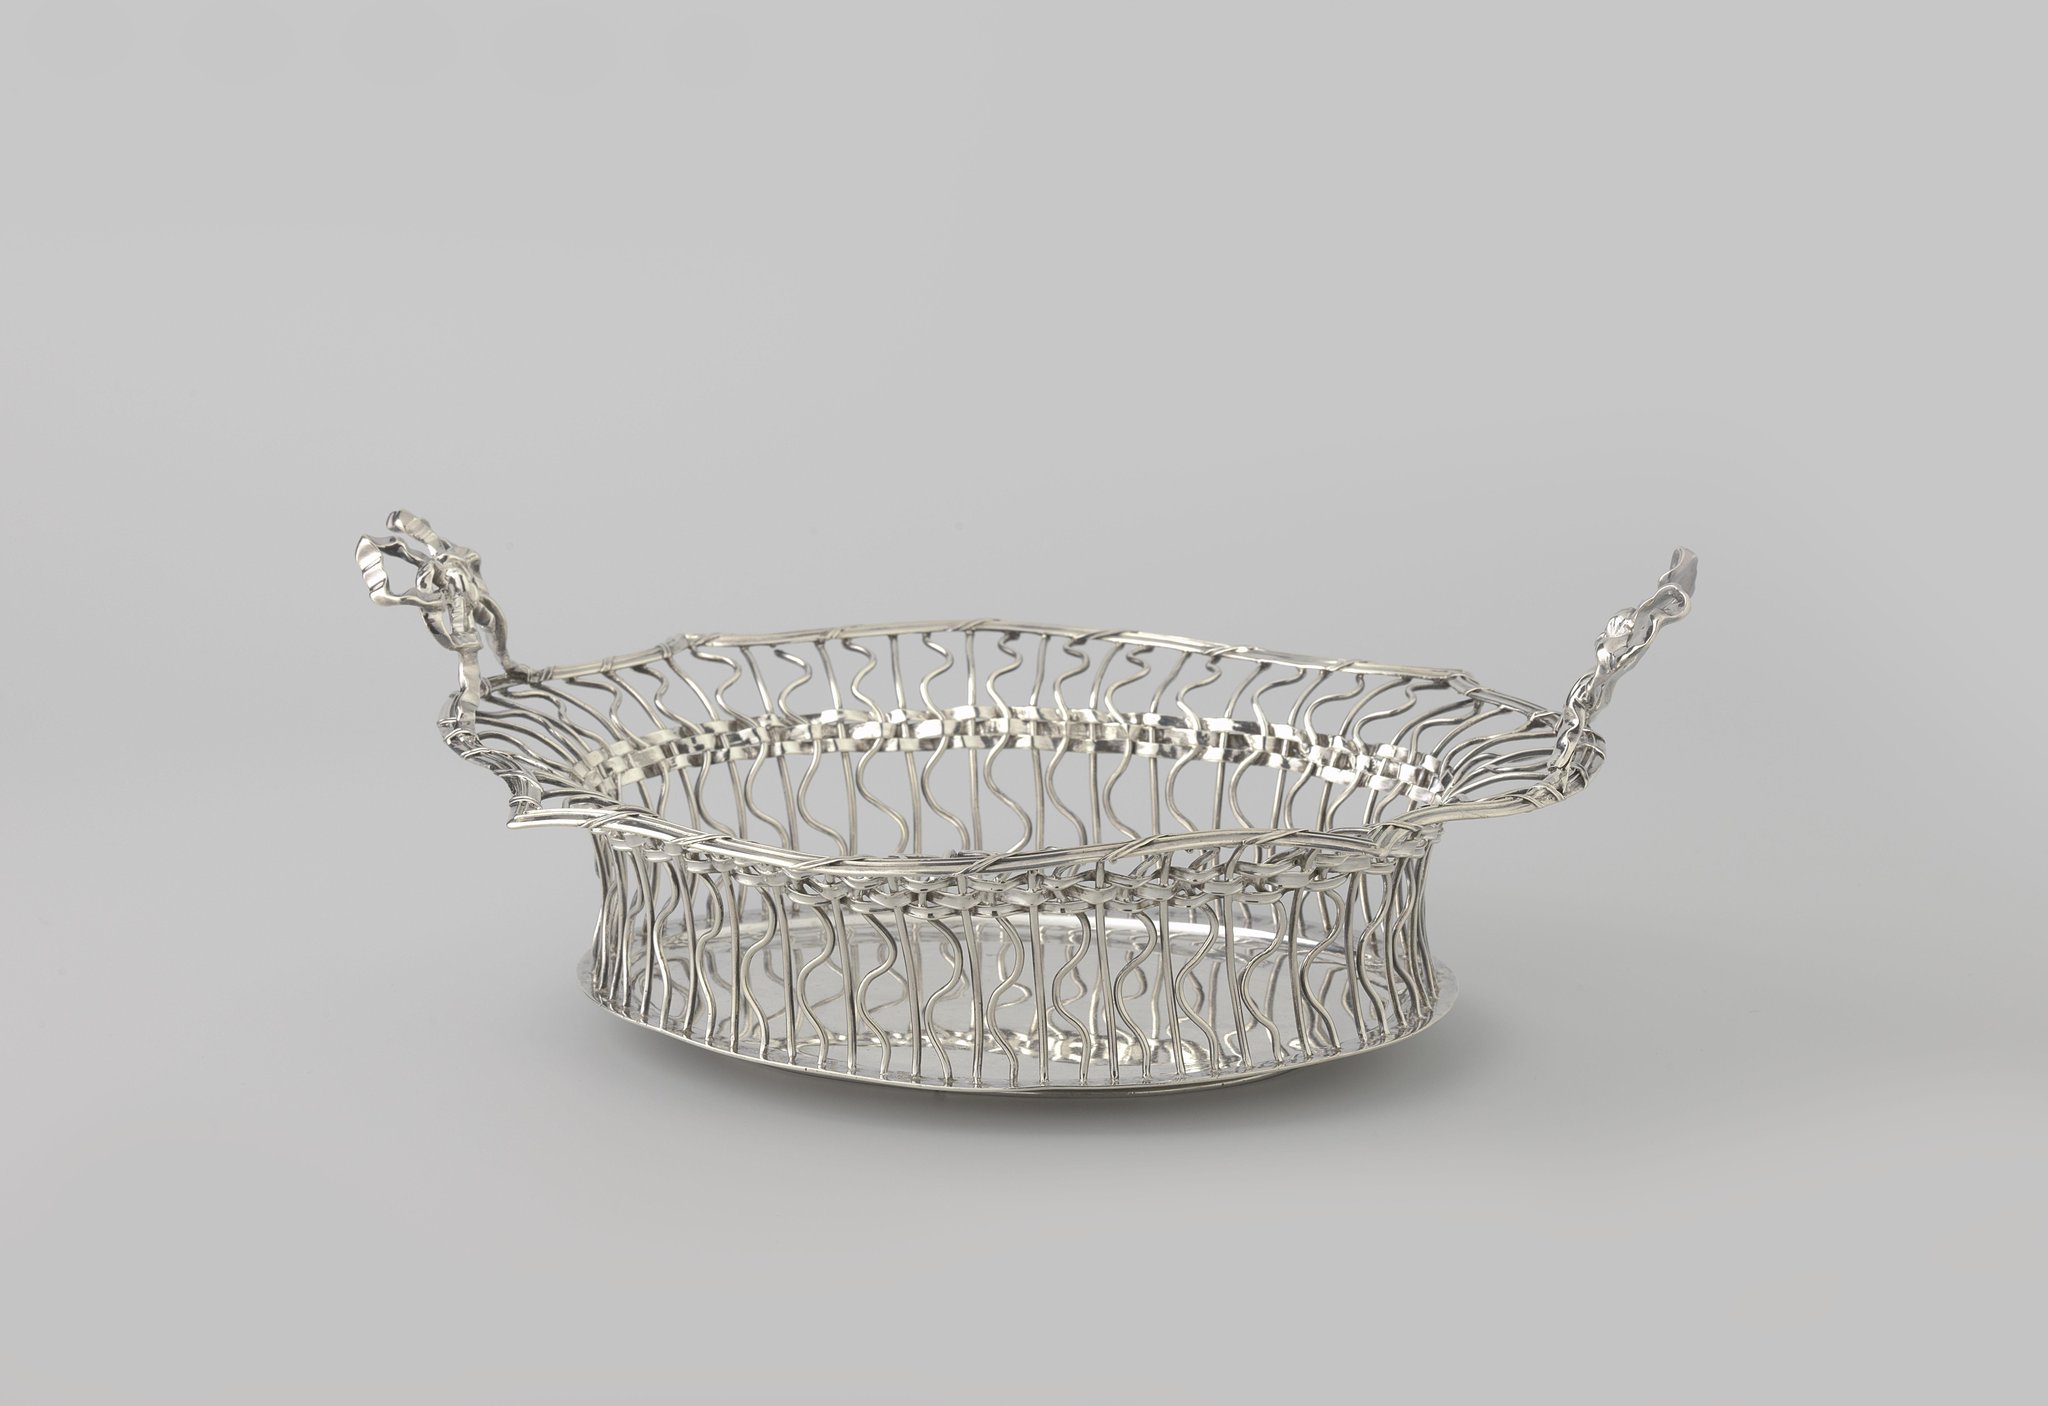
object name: bread basket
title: Broodmand, ovaal, met uit gevlochten draadwerk bestaande wanden en twee strikken als oren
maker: dirk evert grave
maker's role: silversmith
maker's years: 1735-1795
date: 1770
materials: silver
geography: amsterdam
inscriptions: : ‘L’, date letter: ‘L’, maker's mark, town mark, alloy mark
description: De ovale mand rust op een geprofileerde standring. De bodem heeft een verhoogde, platte rand, vanwaaruit de afwisselend rechte en geslingerde draden oprijzen die de gewelfde wand vormen. Waar zij ombuigen naar de geschulpte buitenrand, worden ze verbonden door een drievoudige vlechtband. De geribde buitenrand is omwonden door een lint. De schuin opstaande, gegoten oren hebben de vorm van gestrikte linten.